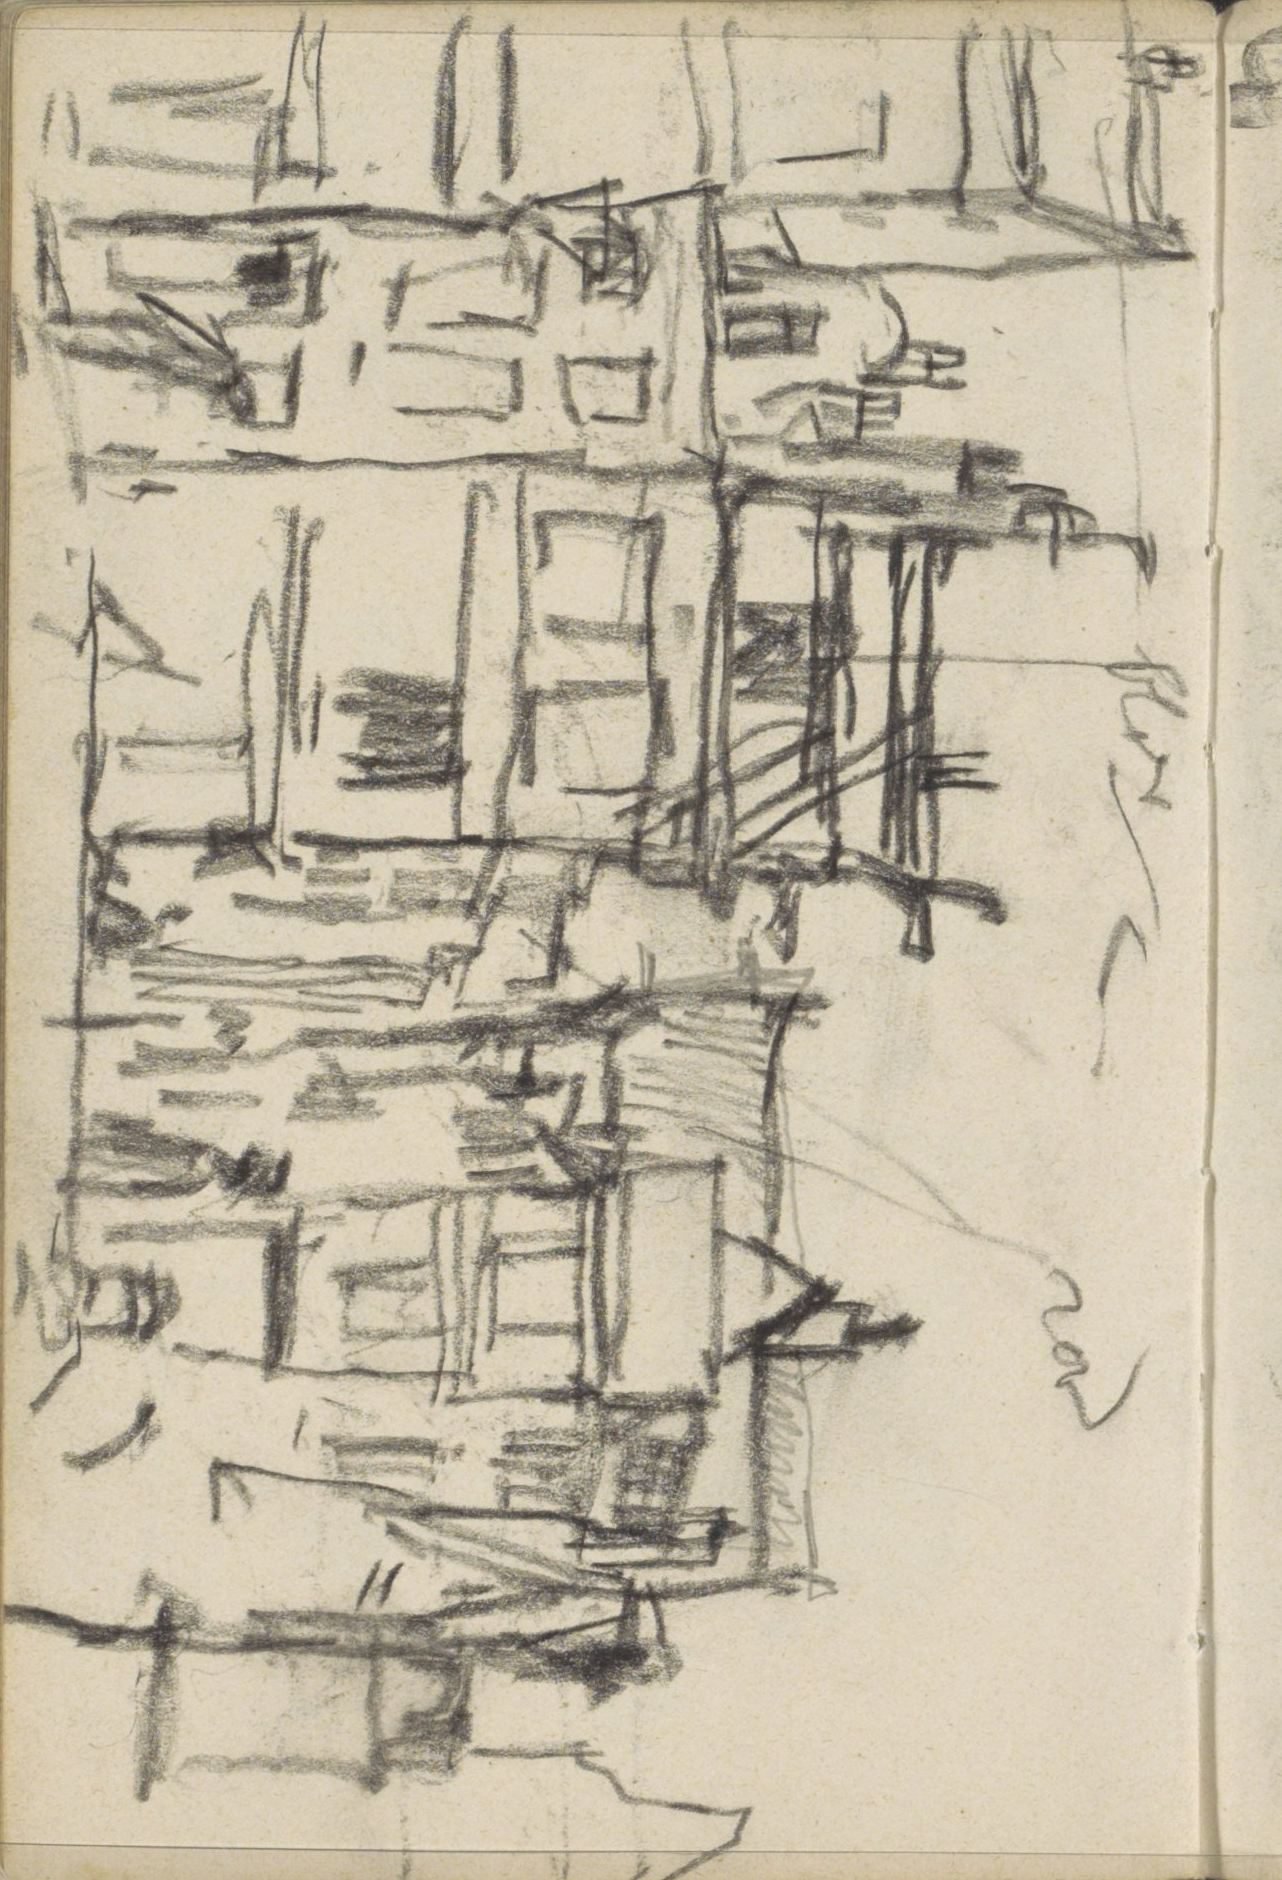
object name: sketchbook leaf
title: Gezicht in Amsterdam, mogelijk het Rokin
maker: george hendrik breitner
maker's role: draughtsman, painter, print maker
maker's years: 1857-1923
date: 1909-1912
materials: chalk, paper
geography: amsterdam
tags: urban housing, canals, waters (in city)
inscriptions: kleurnotitie, handgeschreven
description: Gezicht in Amsterdam, mogelijk het Rokin. Vooraan figuren. Pagina 85 uit een schetsboek met 46 bladen vervaardigd te Amsterdam.